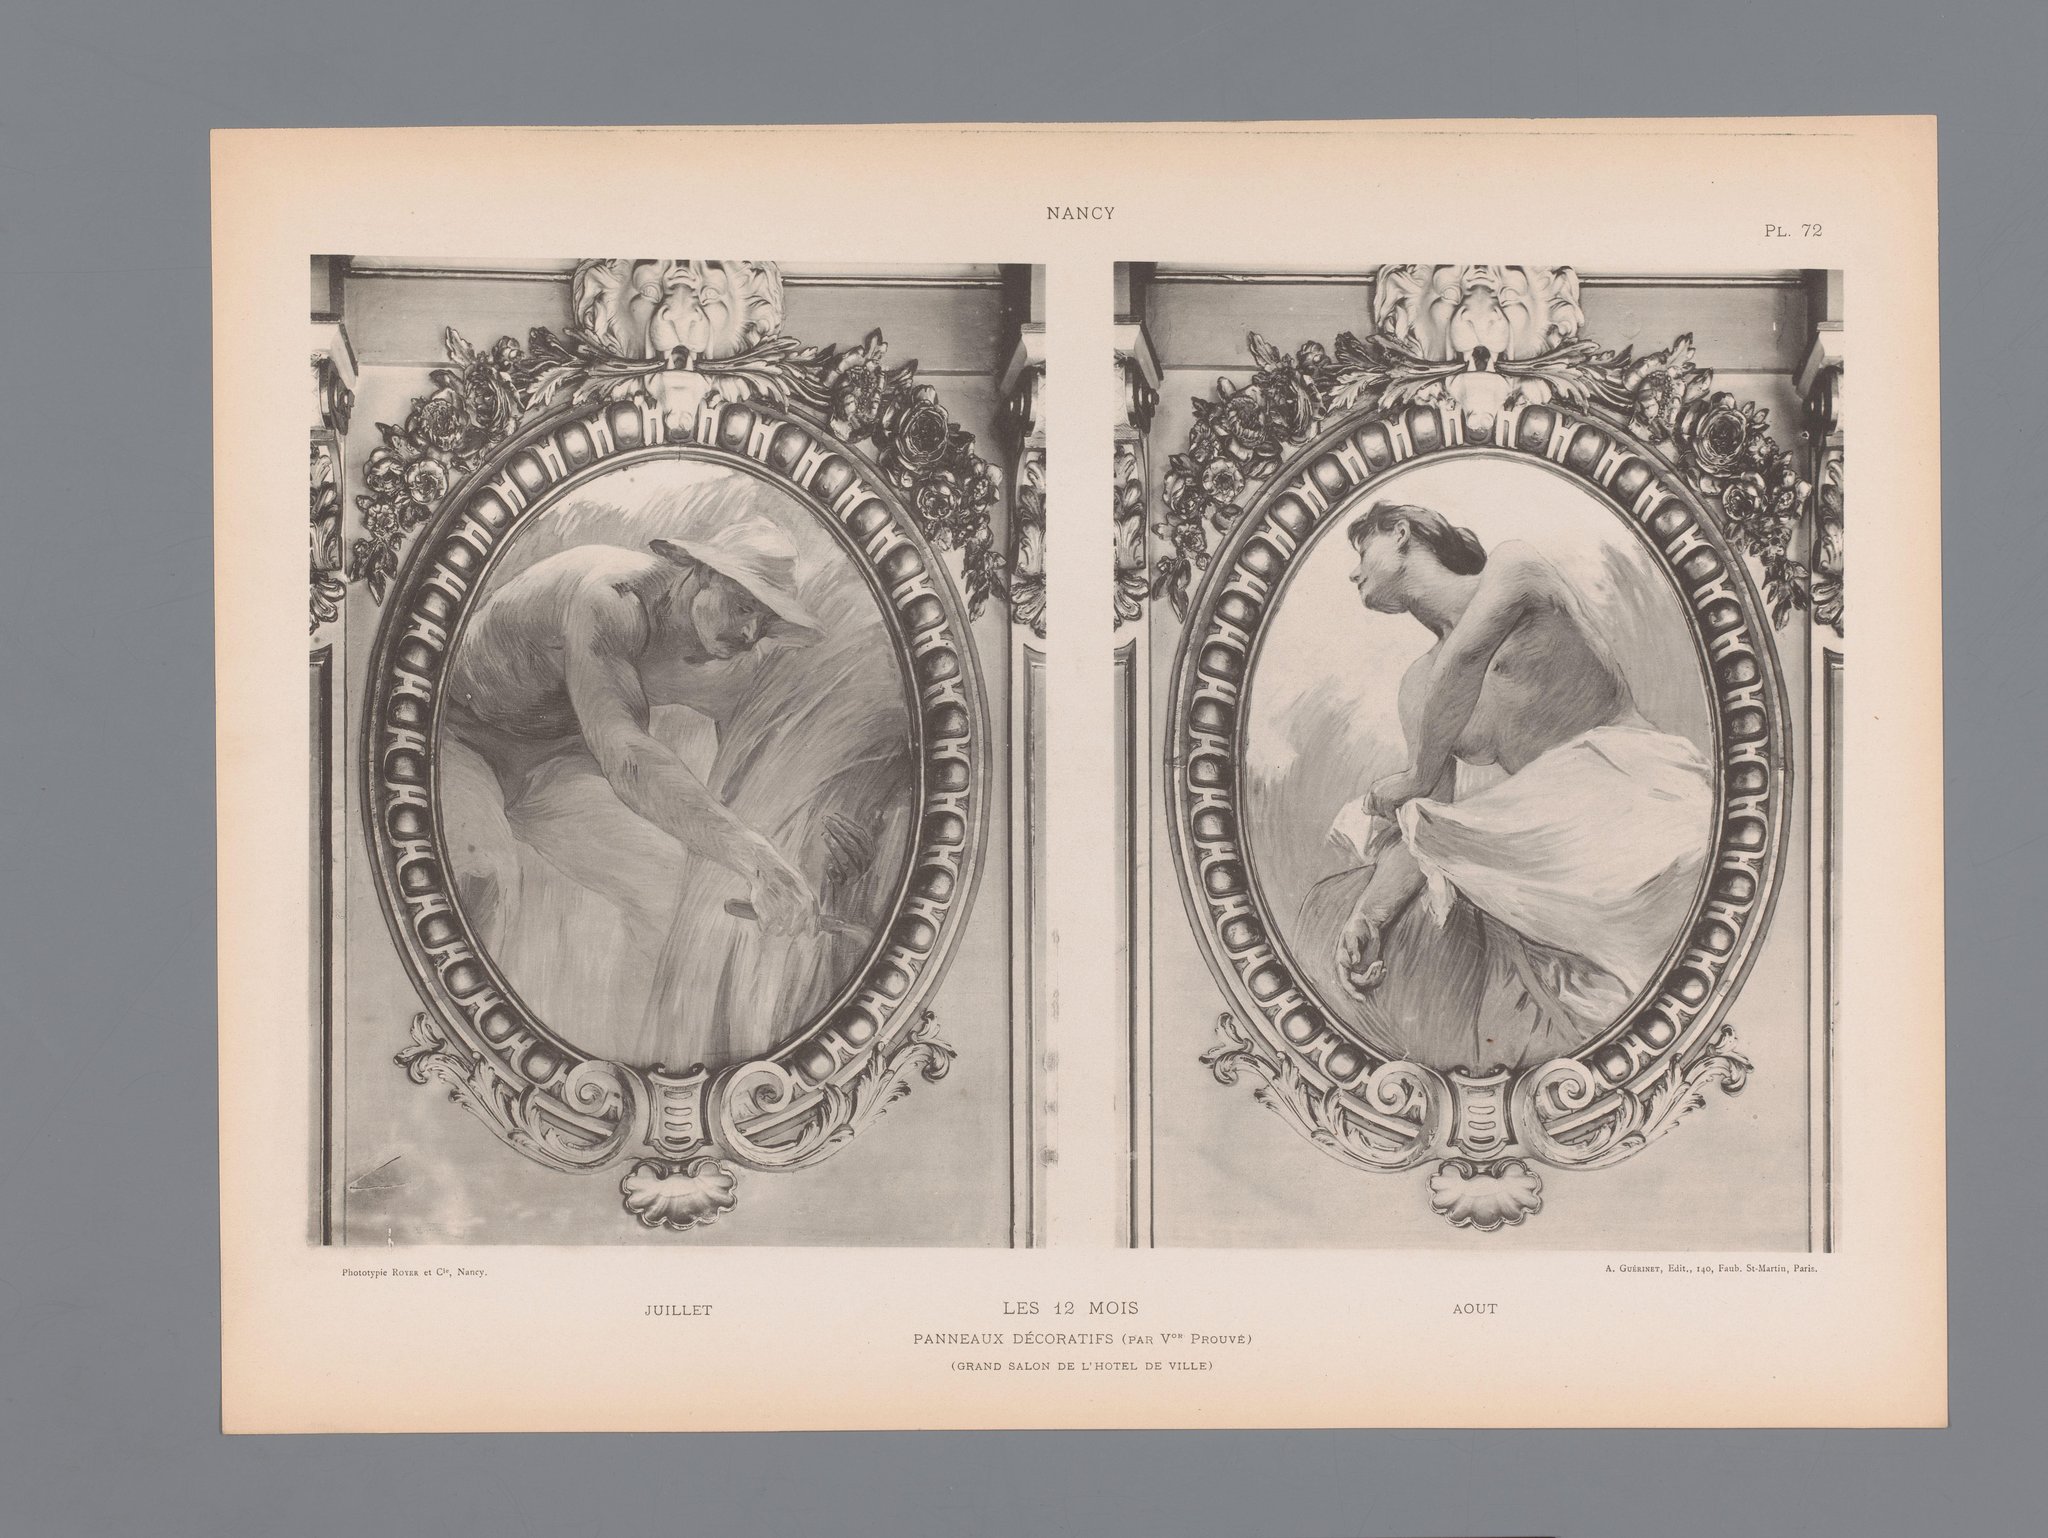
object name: photomechanical print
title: Twee panelen met representaties van juli en augustus in het stadhuis te Nancy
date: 1891-1896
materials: paper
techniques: photograph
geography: paris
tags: townhall, painting (including book-illumination, miniature-painting), june ~ other concepts, july ~ other concepts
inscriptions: inscription: ‘Les 12 Mois/ panneaux décoratifs (par Vor Prouvé)’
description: Deze prent maakt deel uit van een omslag met 103 prenten op 101 bladen en een titelblad.